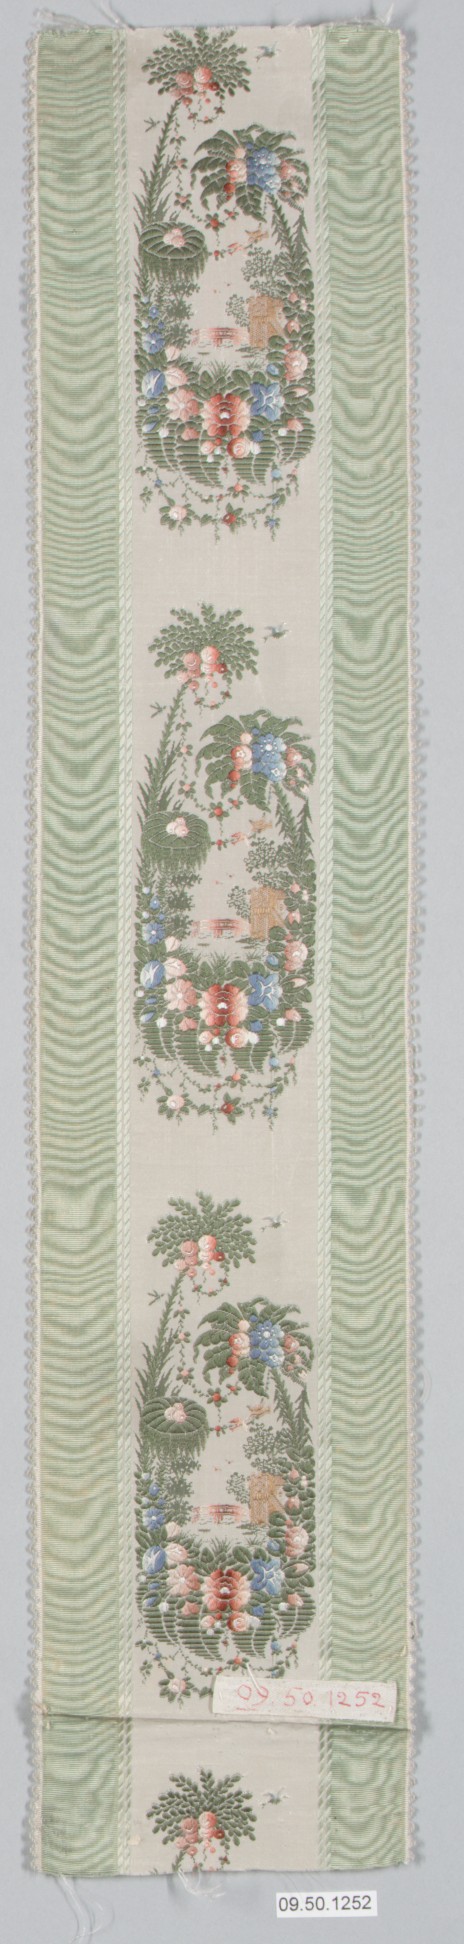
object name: ribbon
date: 1801-1833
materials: silk